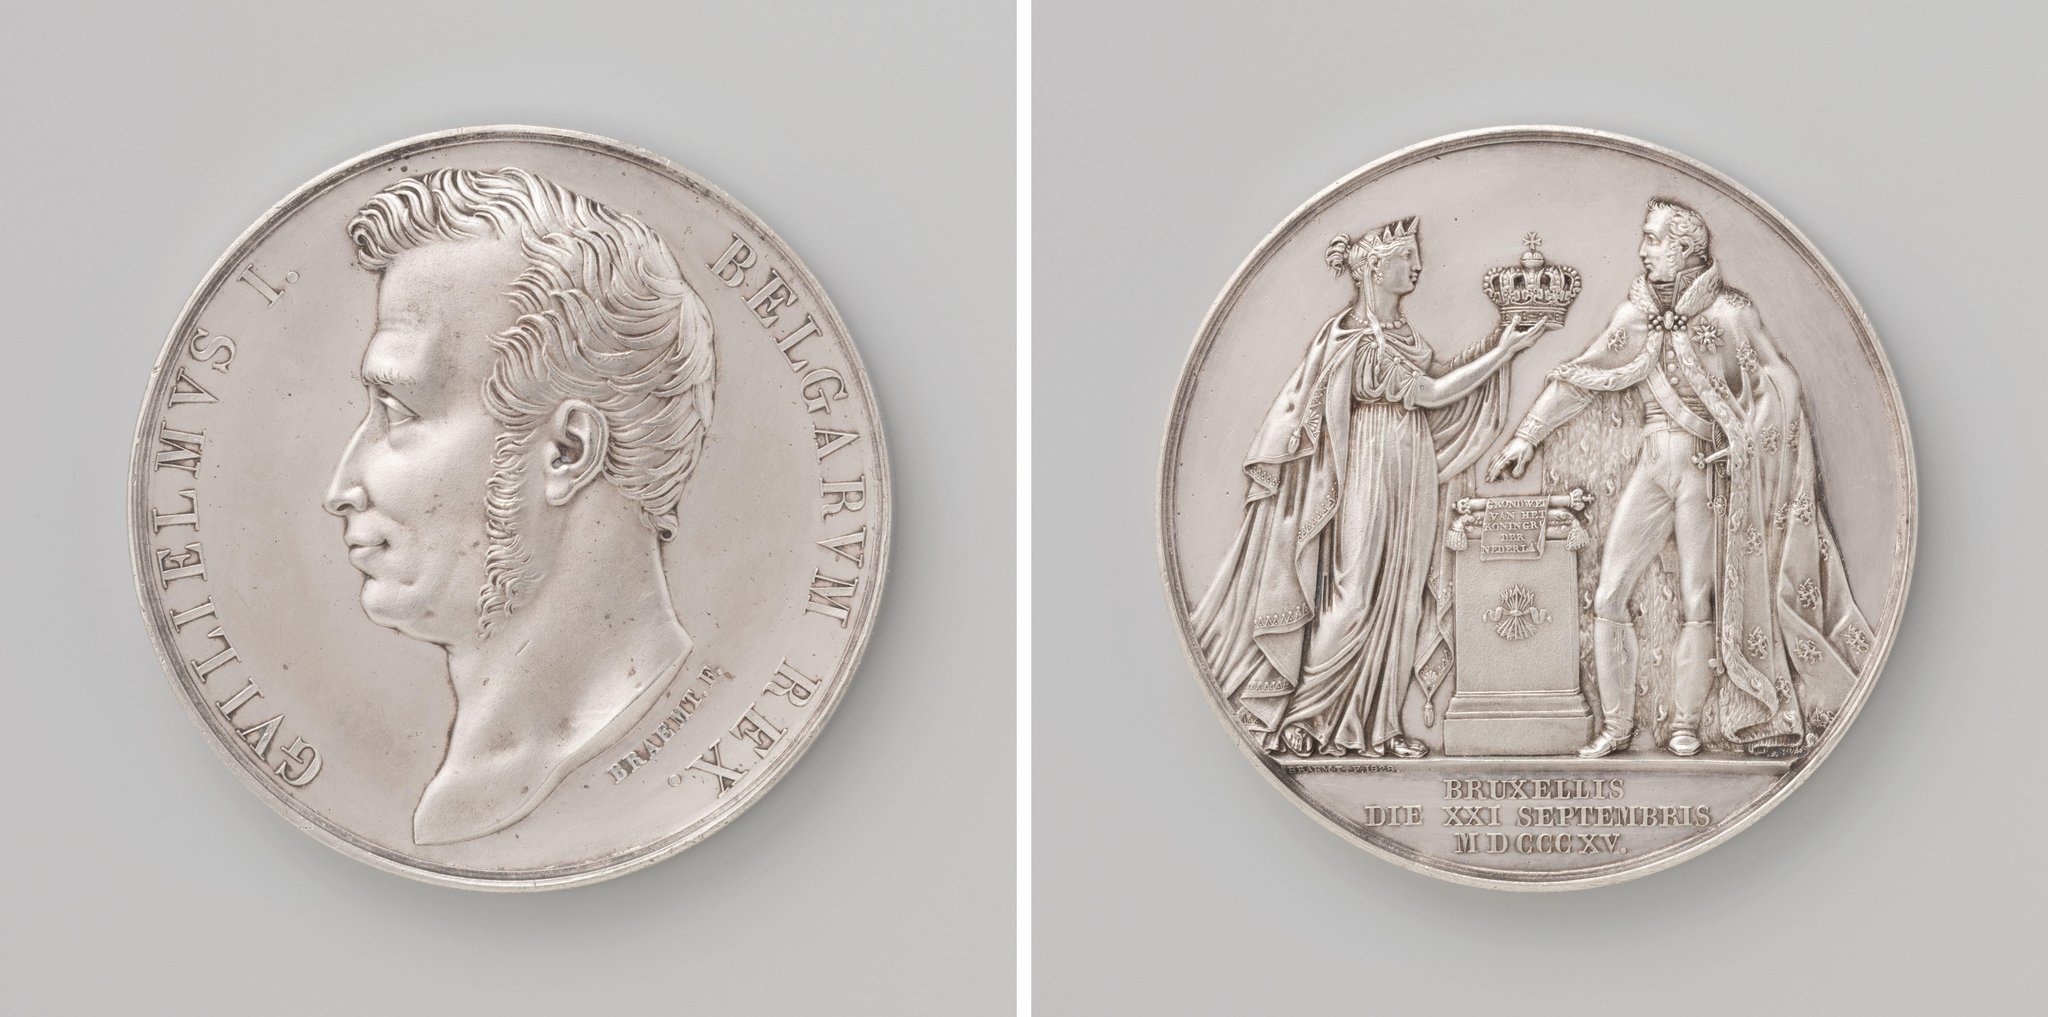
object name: history medal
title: Inhuldiging van Willem I Frederik als koning der Nederlanden te Brussel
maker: joseph pierre braemt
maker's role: print maker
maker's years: 1796-1864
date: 1815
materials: silver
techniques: striking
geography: brussels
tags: the hague, berlin, william i of the netherlands, netherlands, brussels, belgium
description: Zilveren penning. Voorzijde: borststuk man binnen omschrift. Keerzijde: gekroonde Nederlandse maagd in hermelijnen mantel biedt Willem I koningskroon aan, terwijl vorst zweert op grondwet, die tussen beiden in ligt op altaar, waarvan basis pijlenbundel draagt; afsnede: opschrift